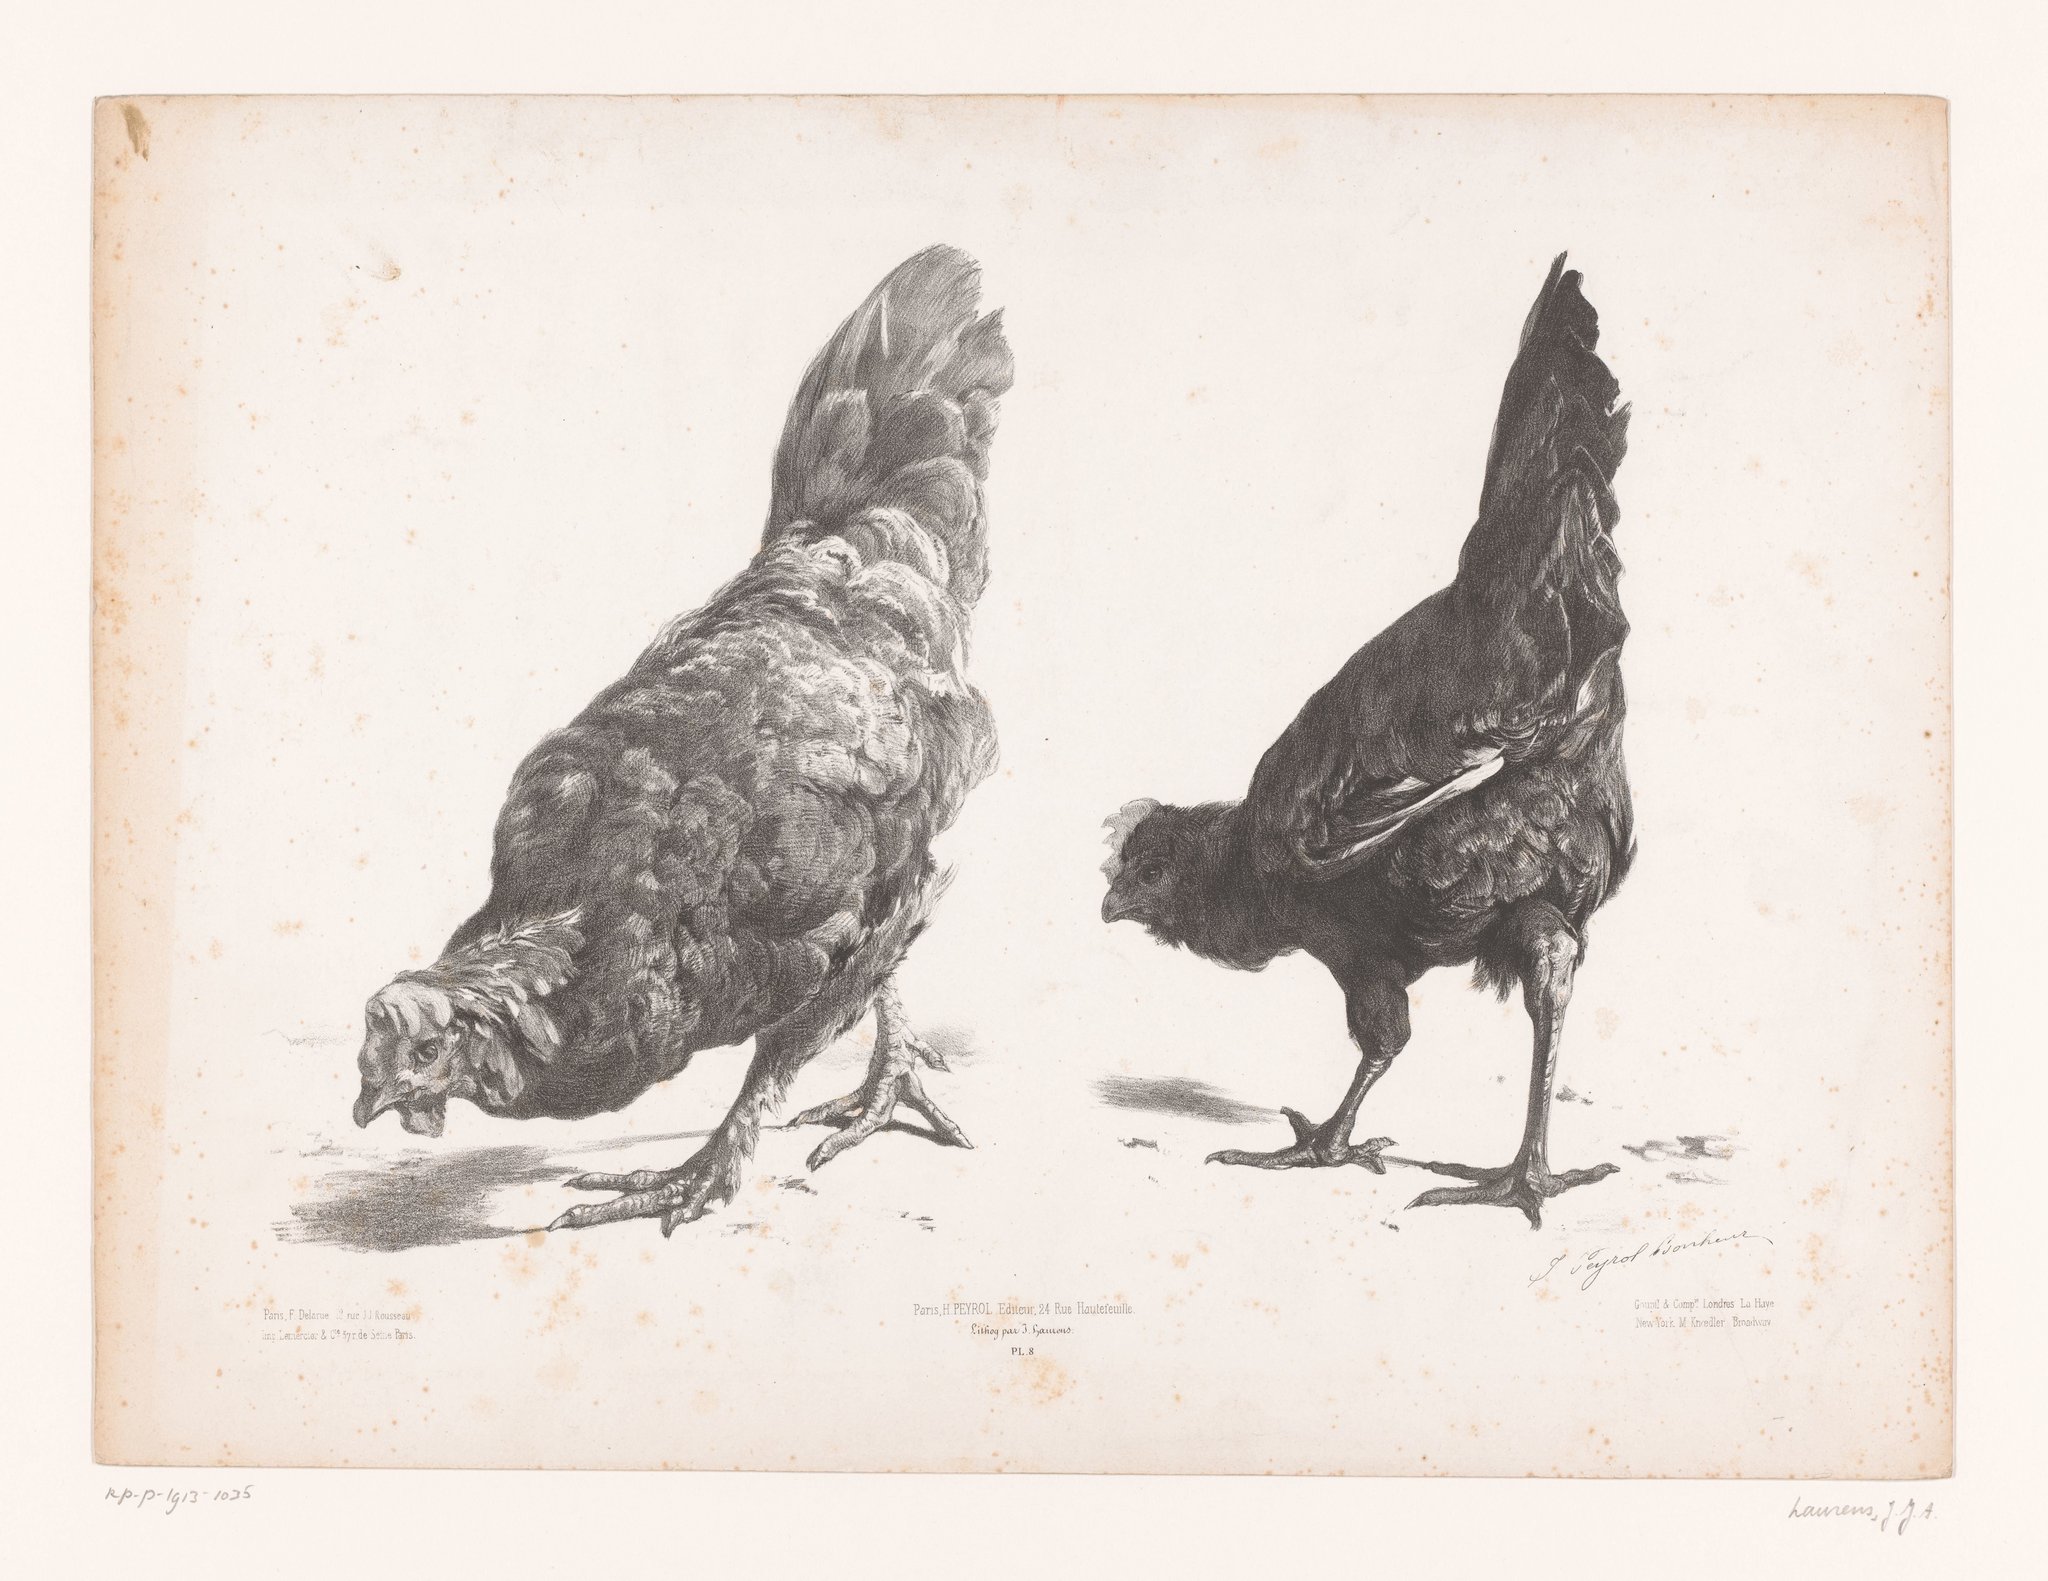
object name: print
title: Studie van twee kippen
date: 1865-1878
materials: paper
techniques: lithograph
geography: paris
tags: fowl (cock, hen, chicken, etc.)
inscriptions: check stamp: Lugt 4777, collector's mark: Lugt 2228a